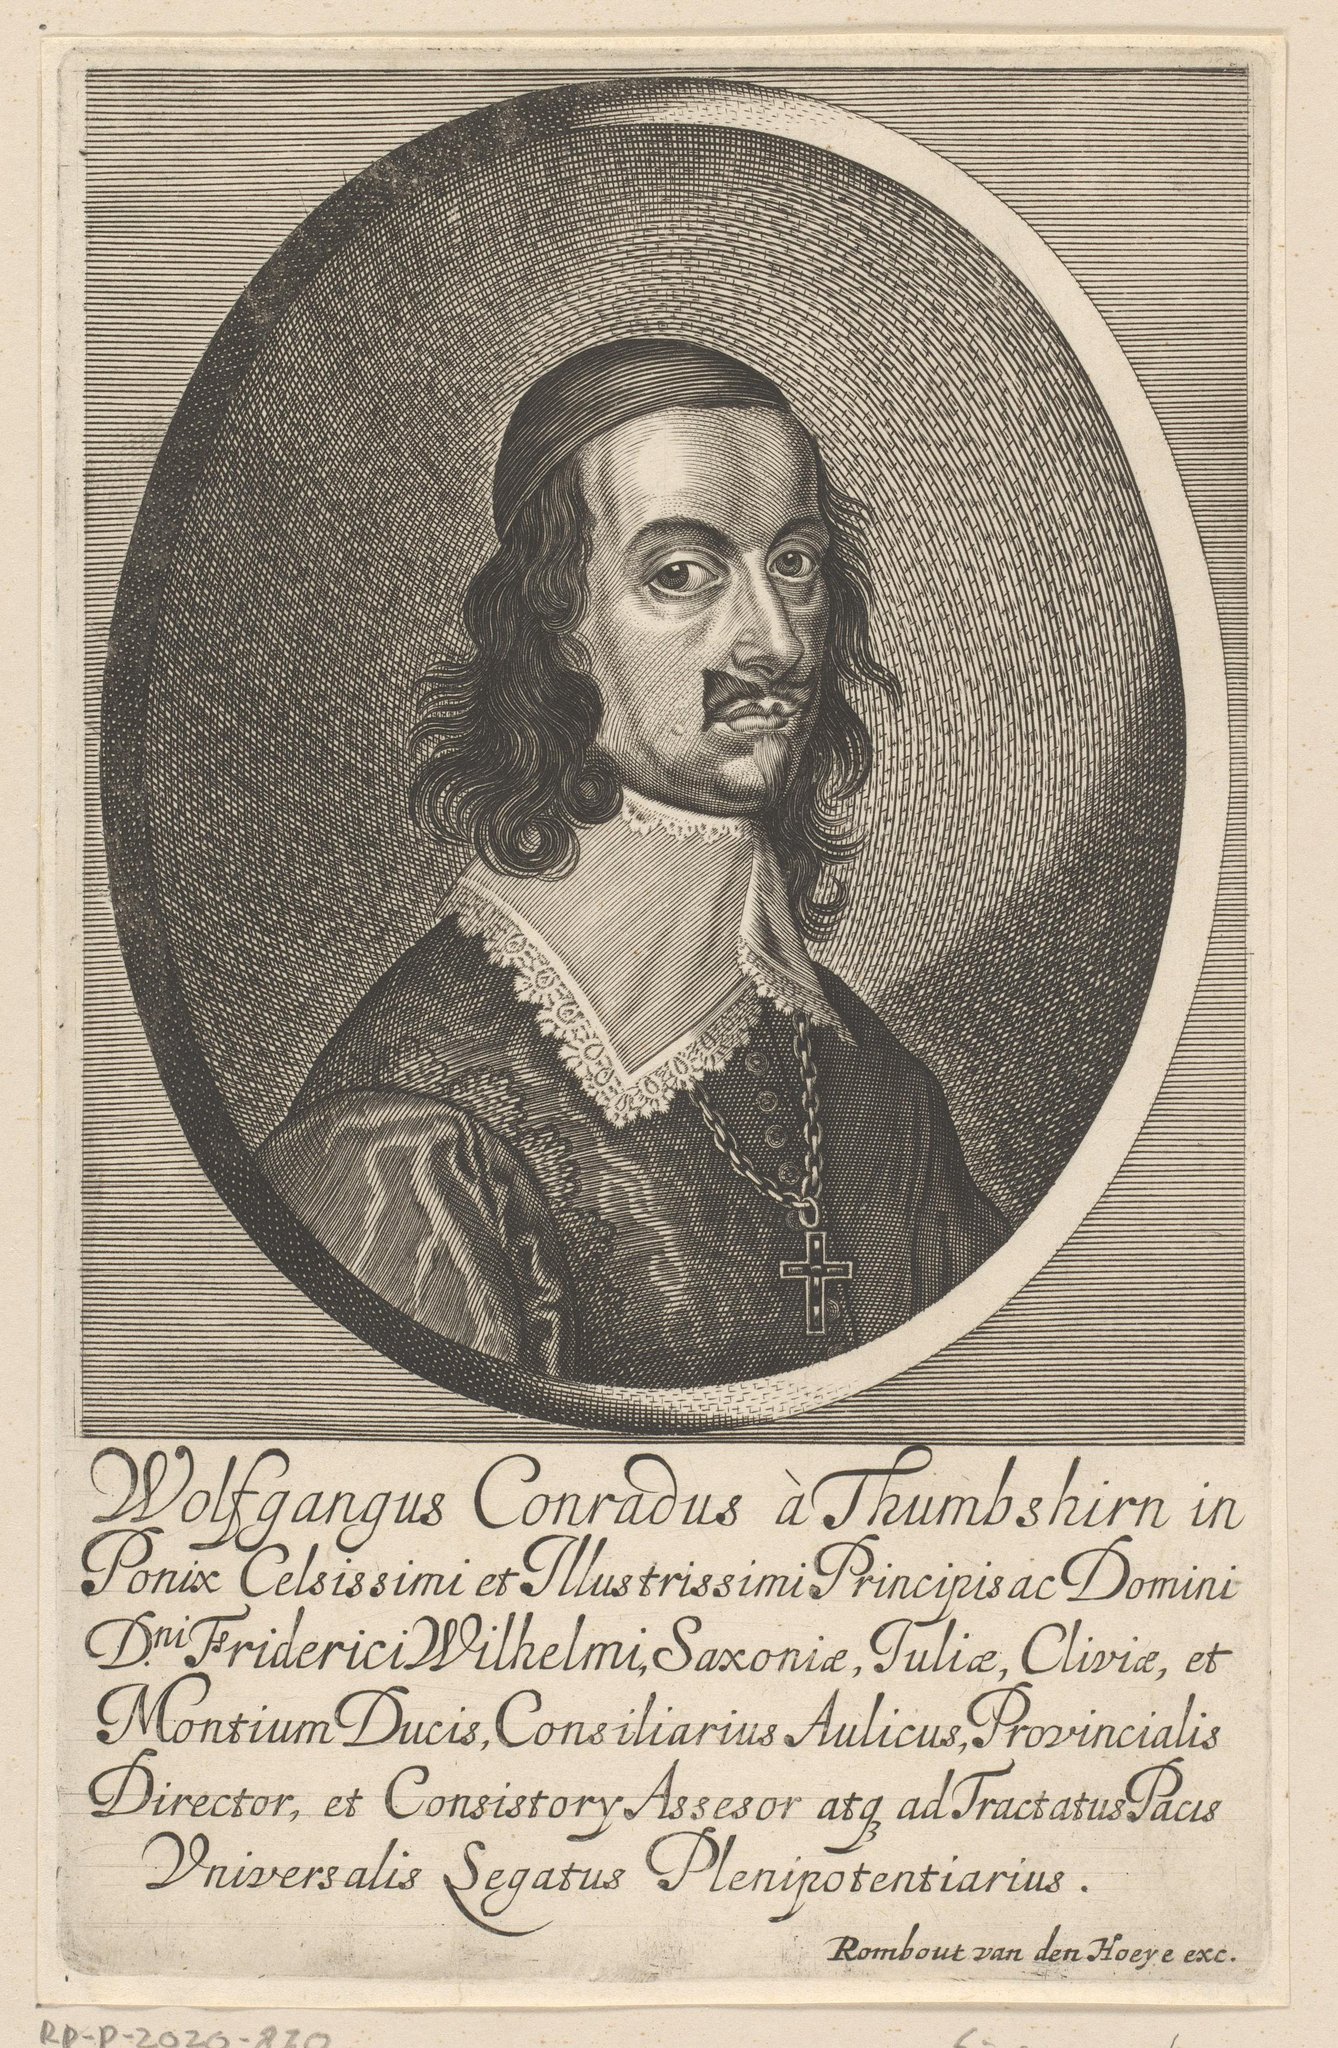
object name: print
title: Portretten van vredesonderhandelaars in Westfalen 1641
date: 1644-1671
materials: paper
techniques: engraving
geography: amsterdam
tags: official; civil servant; functionary (in general), historical persons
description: Prent maakt deel uit van een serie van 43 prenten. Eerdere staat van prent gebruikt in de serie 'Icones legatorum Monasterii et Osnabrugae existentium', uitgegeven door Abraham van Waesbergen in Amsterdam.